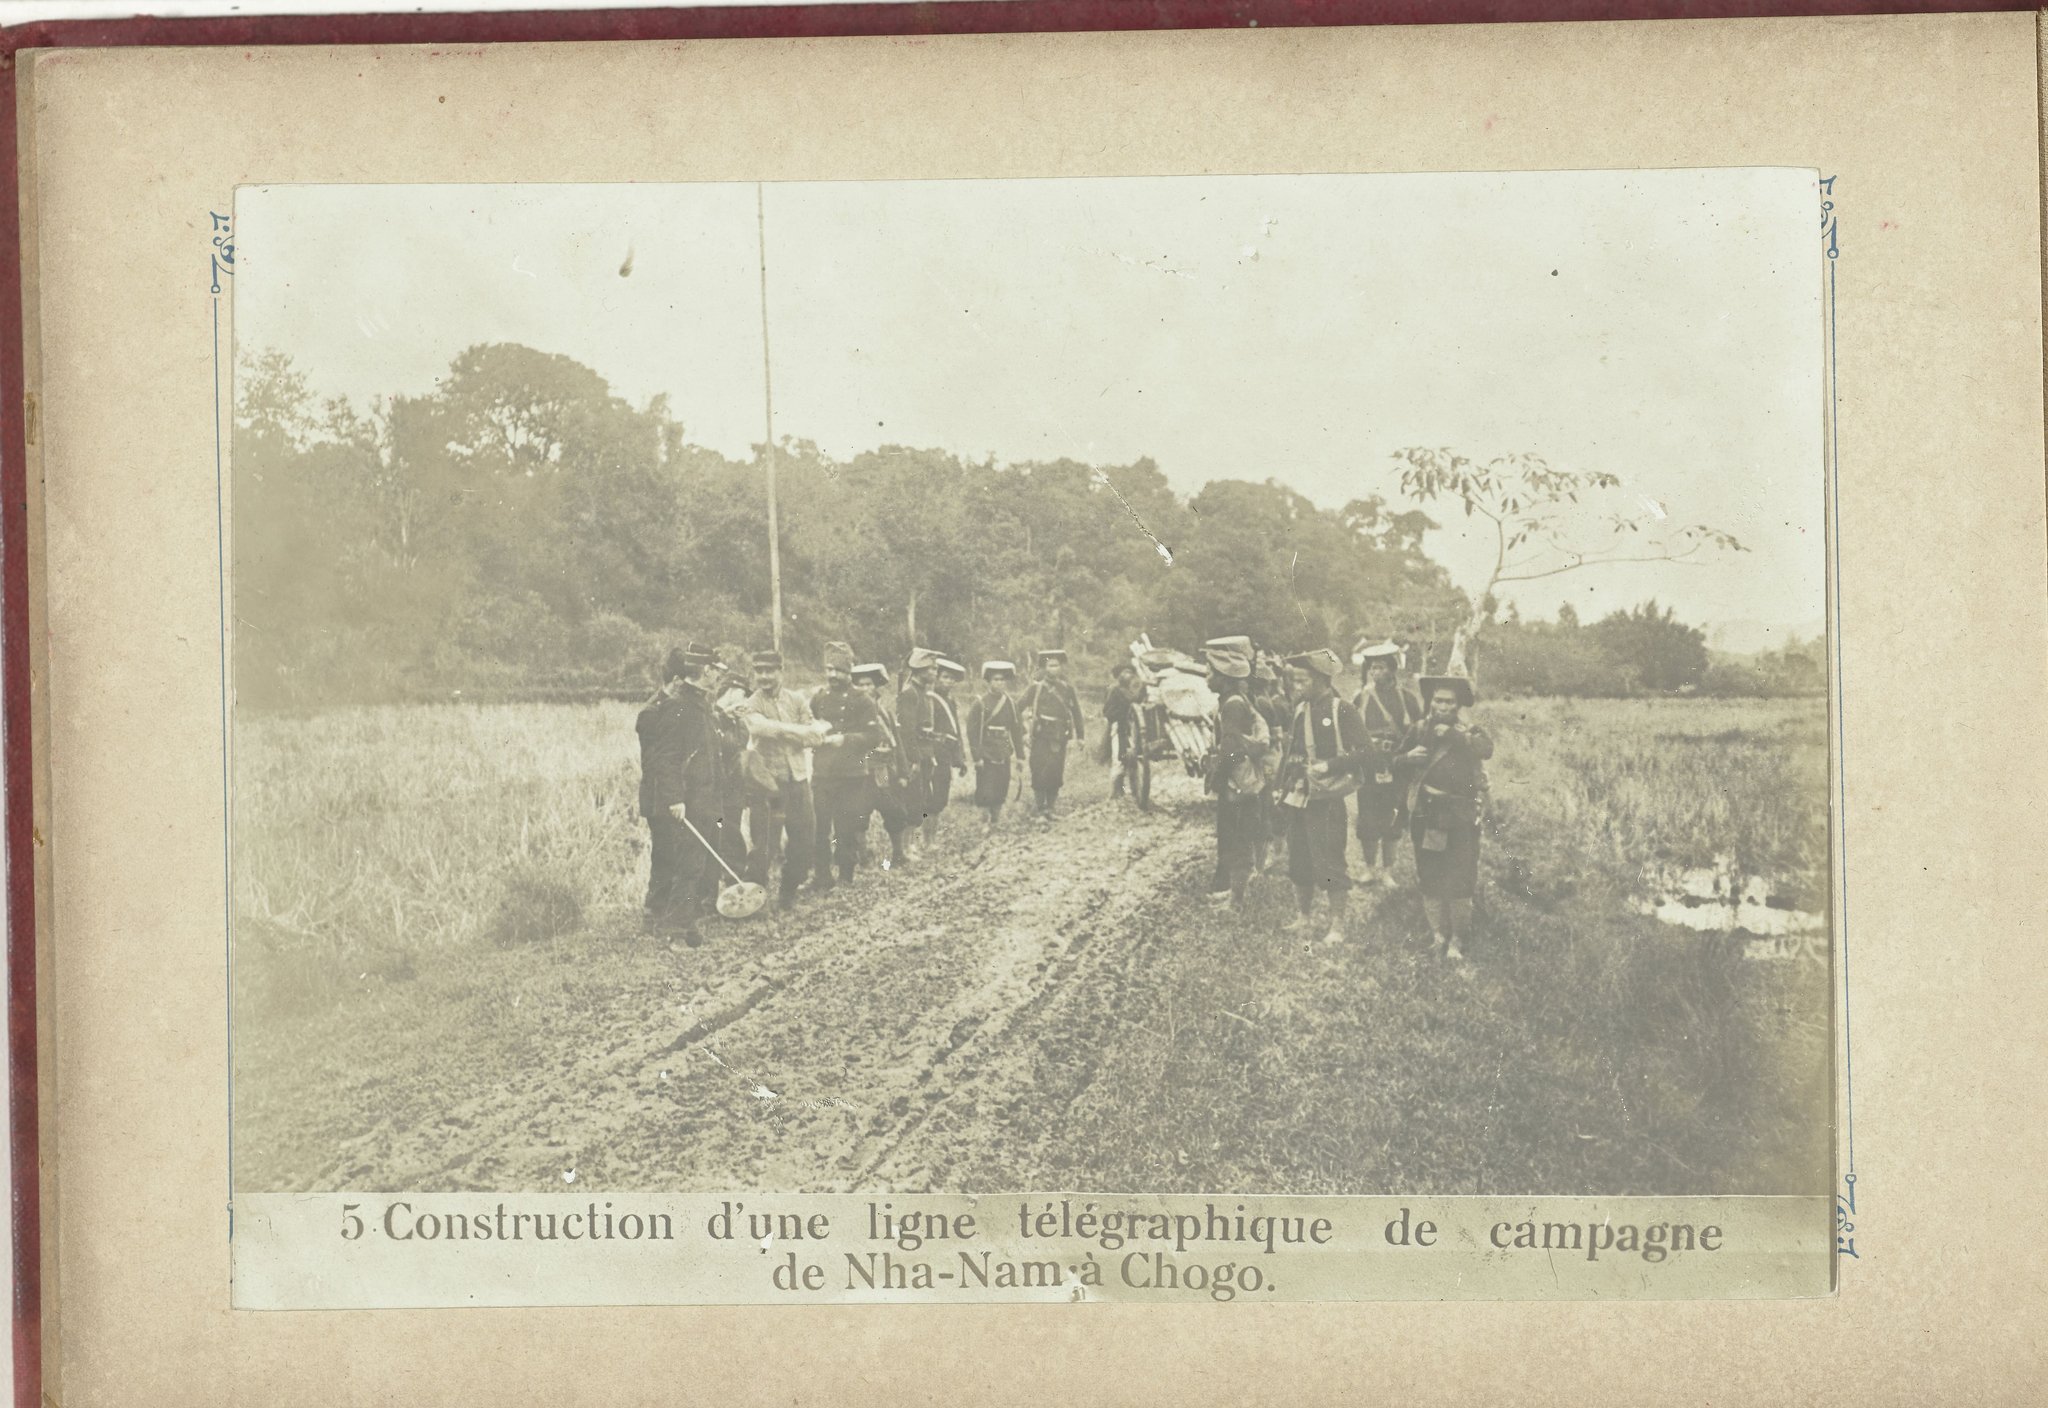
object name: album leaf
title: Aanleg van een telegraaflijn in Nha-Nam, Frans-Indochina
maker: Anonymous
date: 1902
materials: paper, cardboard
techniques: gelatin silver print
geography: vietnam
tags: telegraph pole, telephone pole, road, path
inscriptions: title: ‘5. Construction d'une ligne télégraphique de campagne/ de Nha-Nam à Chogo’